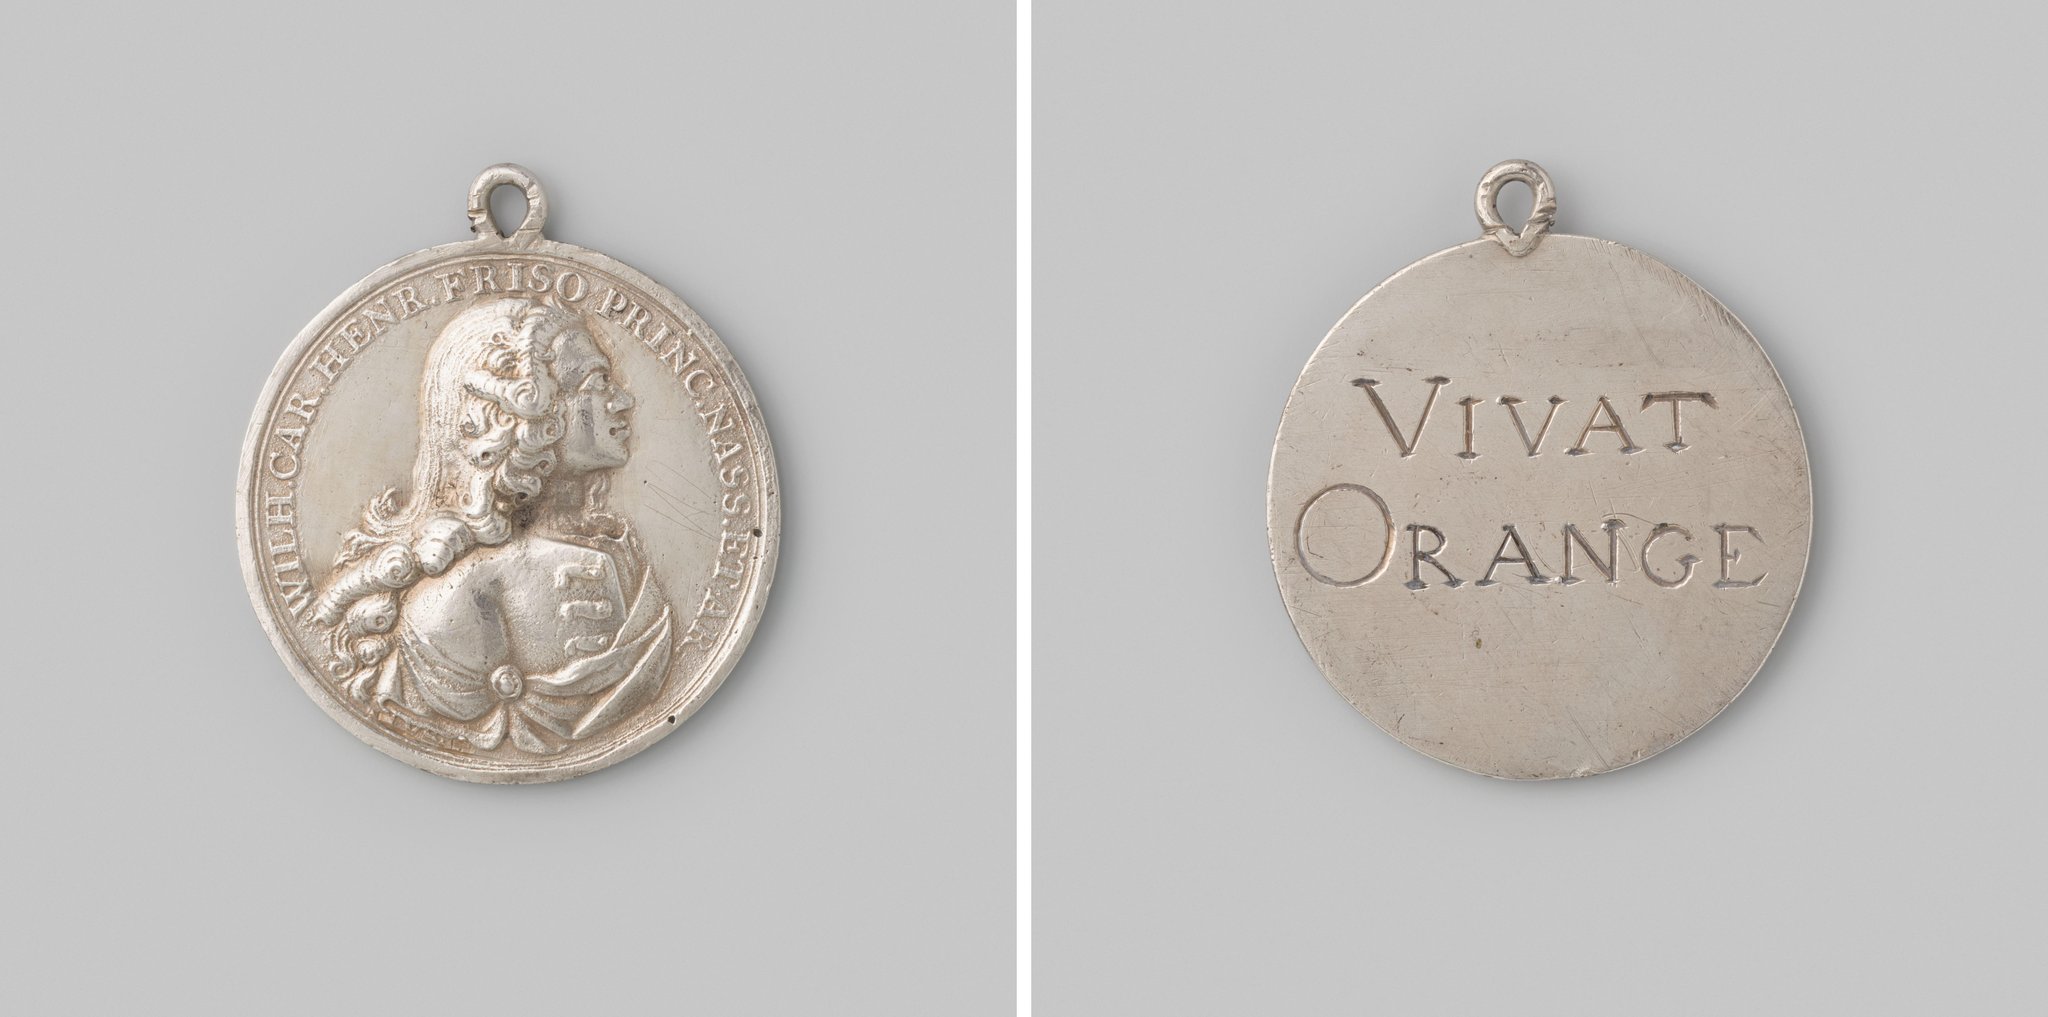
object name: insignia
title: Verheffing van Willem IV, prins van Oranje-Nassau tot stadhouder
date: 1747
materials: silver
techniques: casting, engraving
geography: netherlands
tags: the hague, willem iv (prins van oranje-nassau)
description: Zilveren draagteken aan draagoog. Voorzijde: borststuk man binnen omschrift. Keerzijde: opschrift